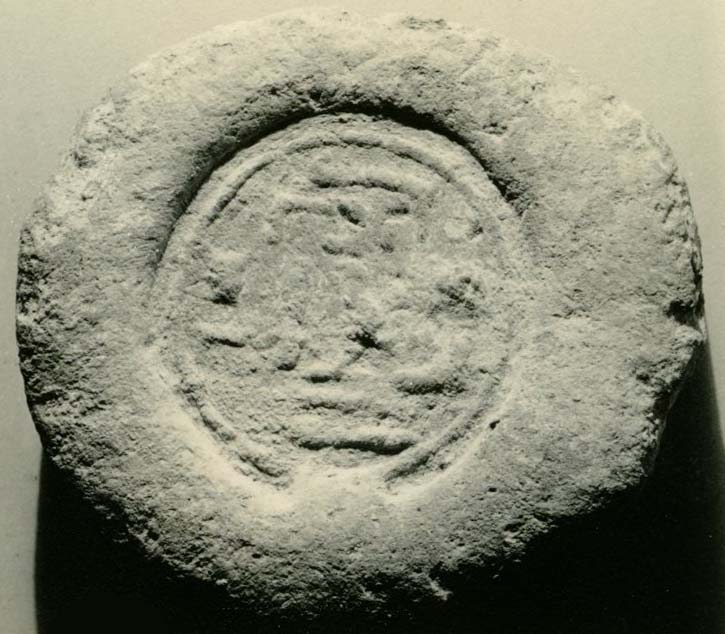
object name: cone, pentjebu, circular impression, steward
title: Funerary Cone of the Steward Pentjebu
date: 1550-1295 BCE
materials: pottery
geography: egypt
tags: hieroglyphs